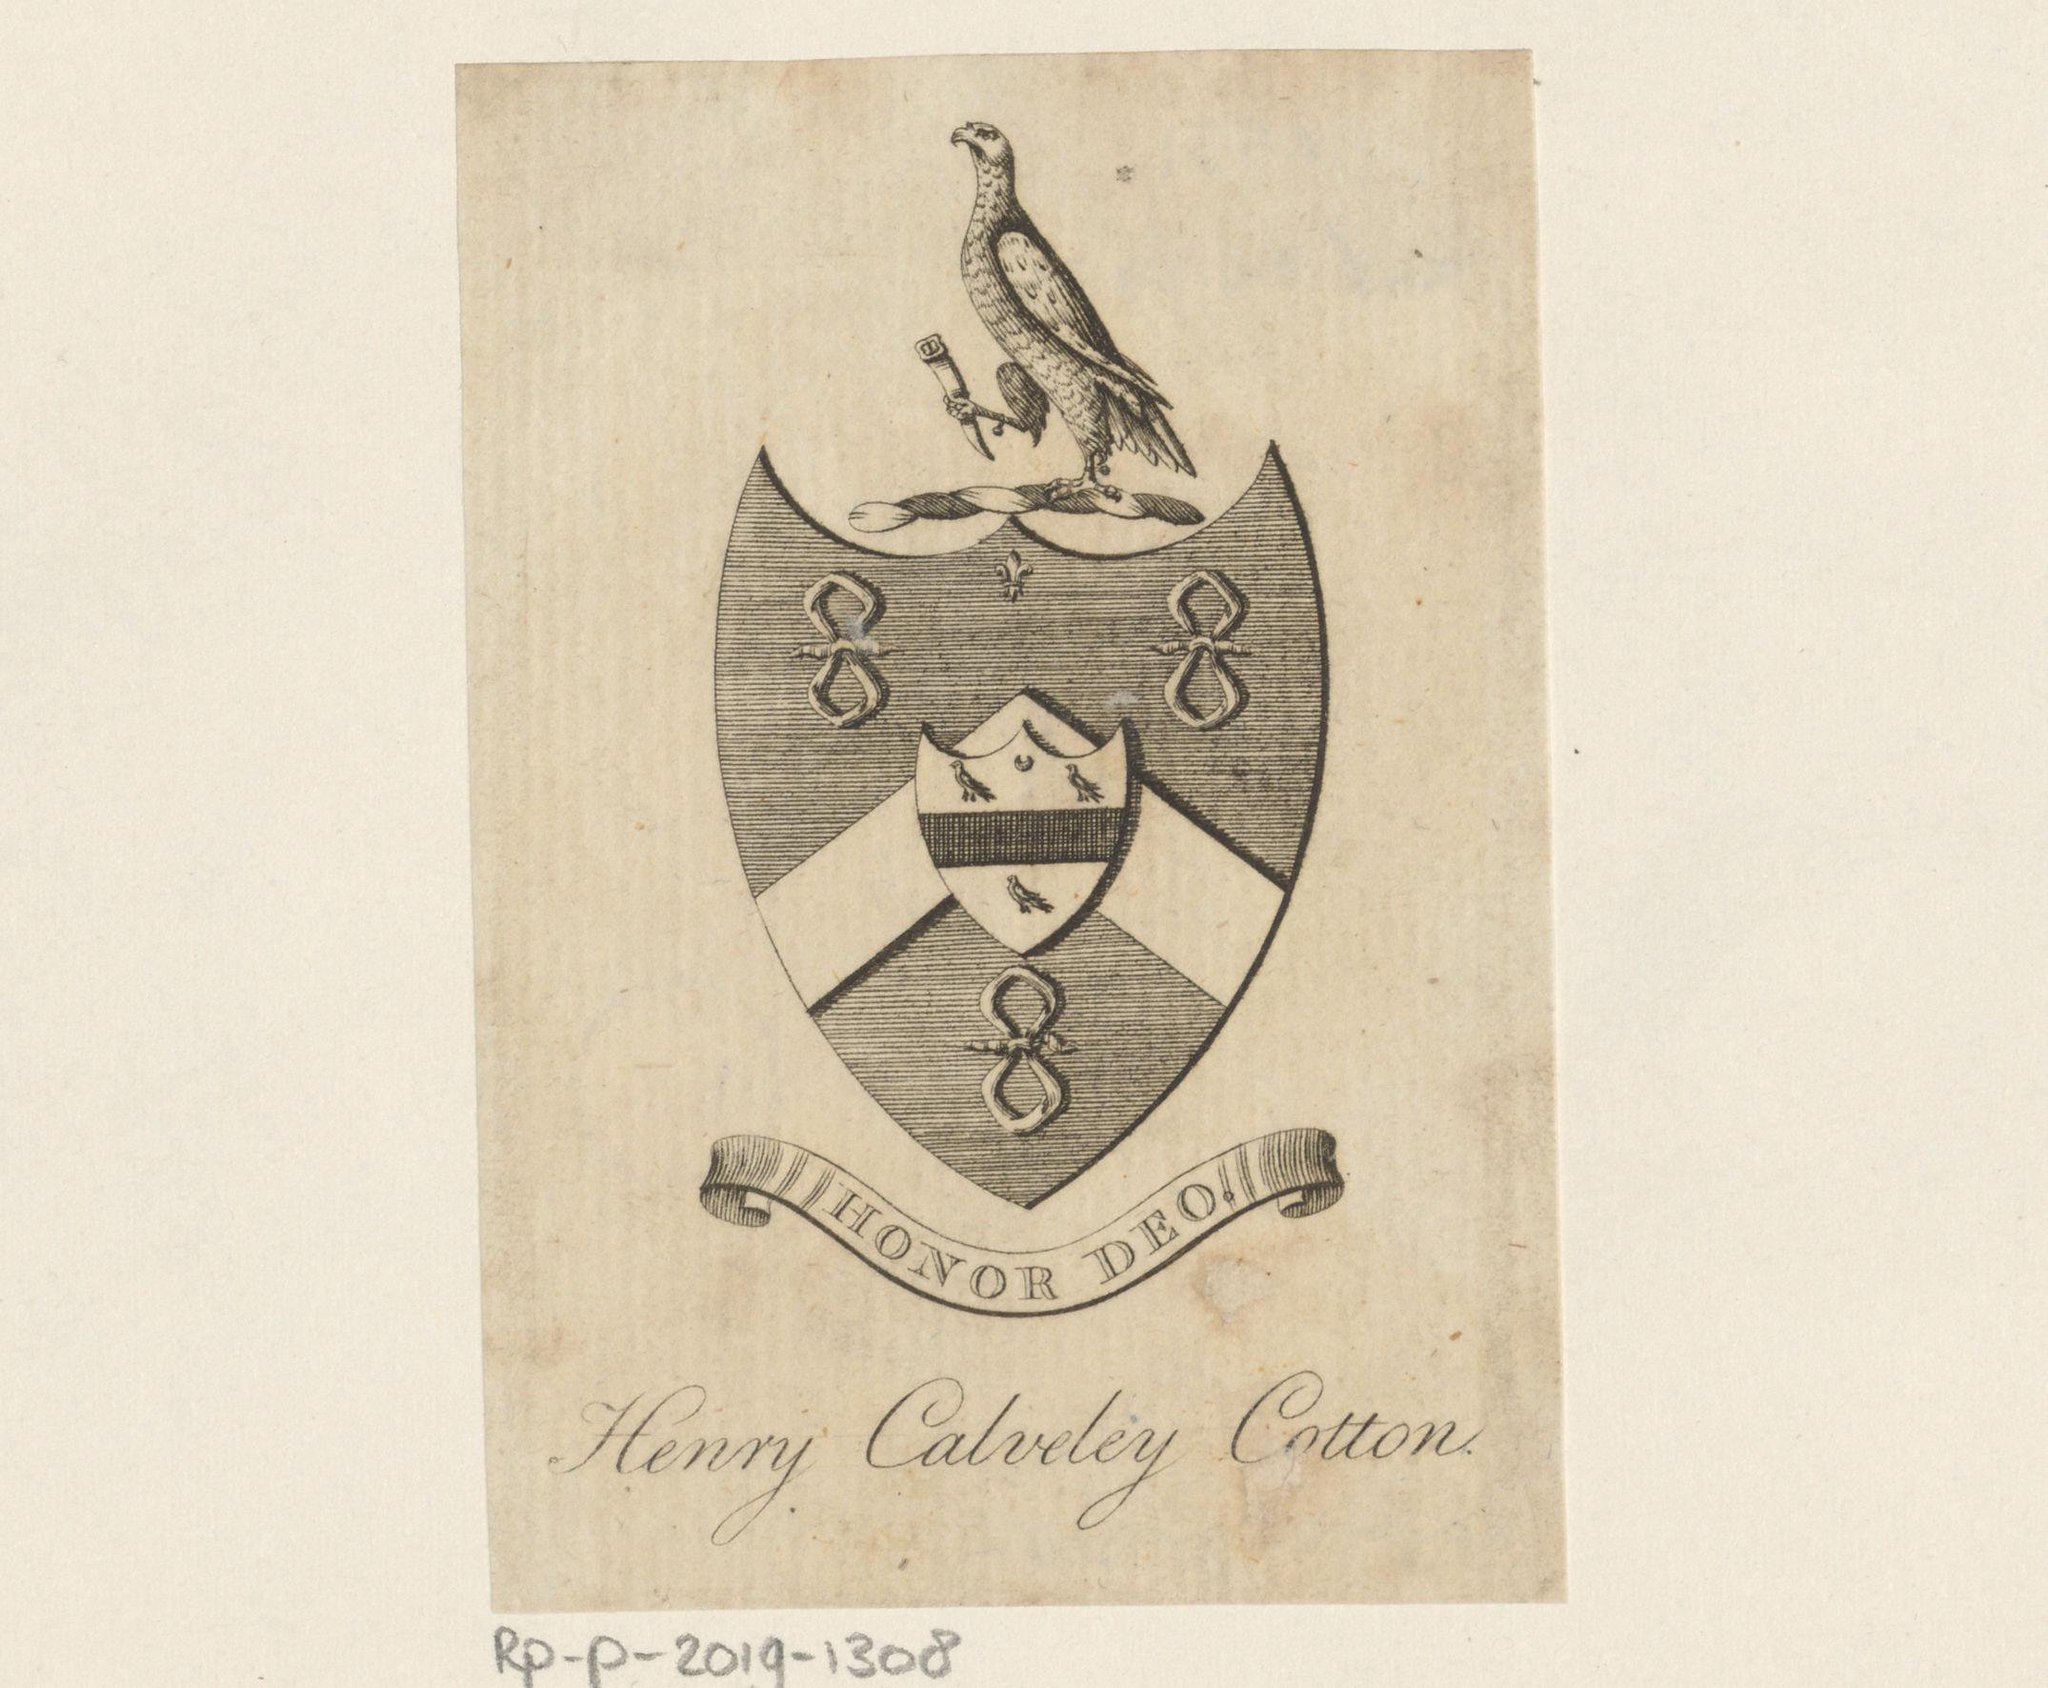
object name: bookplate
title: Ex libris van Henry Calveley Cotton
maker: Anonymous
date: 1765-1837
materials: paper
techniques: engraving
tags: armorial bearing, heraldry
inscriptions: collector's mark: ‘B.K.’